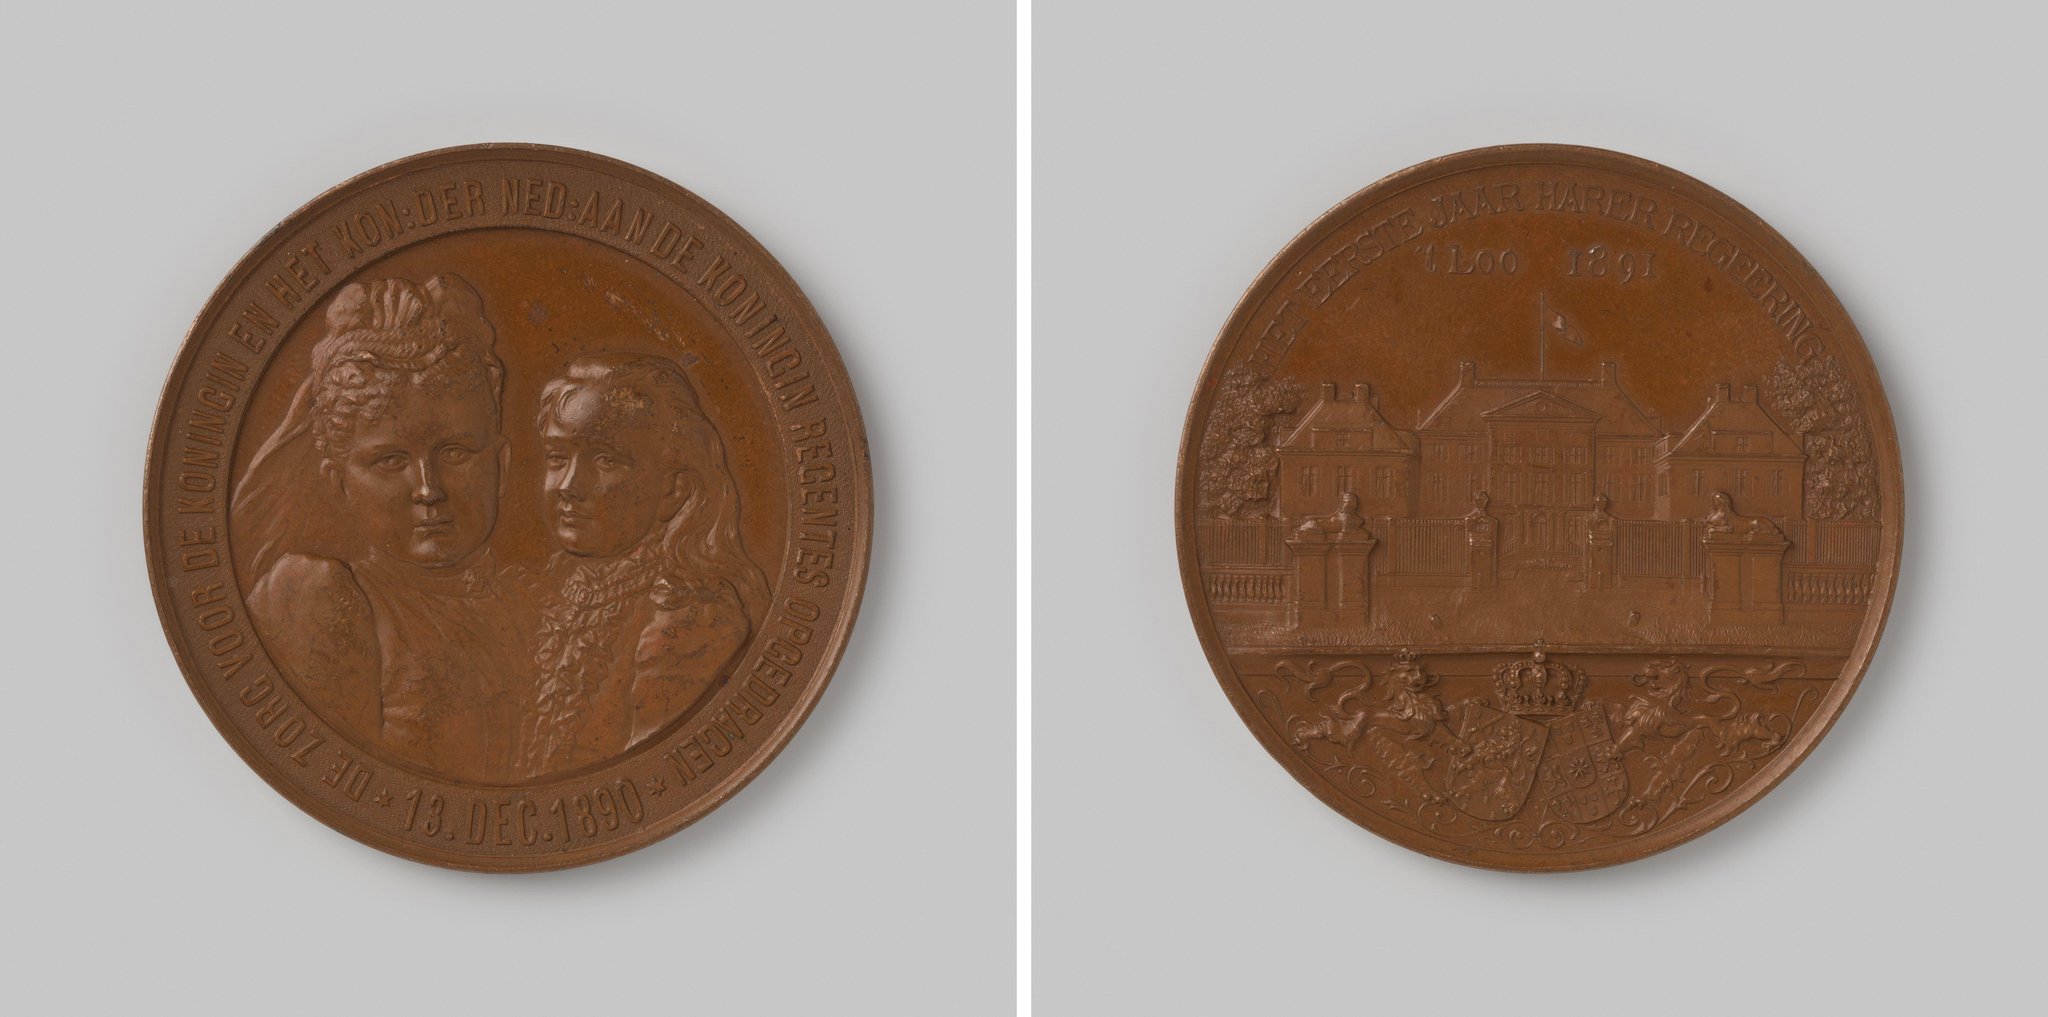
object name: history medal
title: Het regentschap over Koningin Wilhelmina en Nederland aan Koningin Emma opgedragen 1891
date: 1891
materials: bronze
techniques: striking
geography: nuremberg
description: Bronzen penning, op de voorzijde naast elkaar de half aanziende borstbeelden van Emma en Wilhelmina met omschrift, op de keerzijde het aanzicht van Paleis Het Loo met bovenaan twee regels tekst en in afsnede de wapenschilden van Nederland en Koningin Emma onder één kroon met leeuwen als dragers.